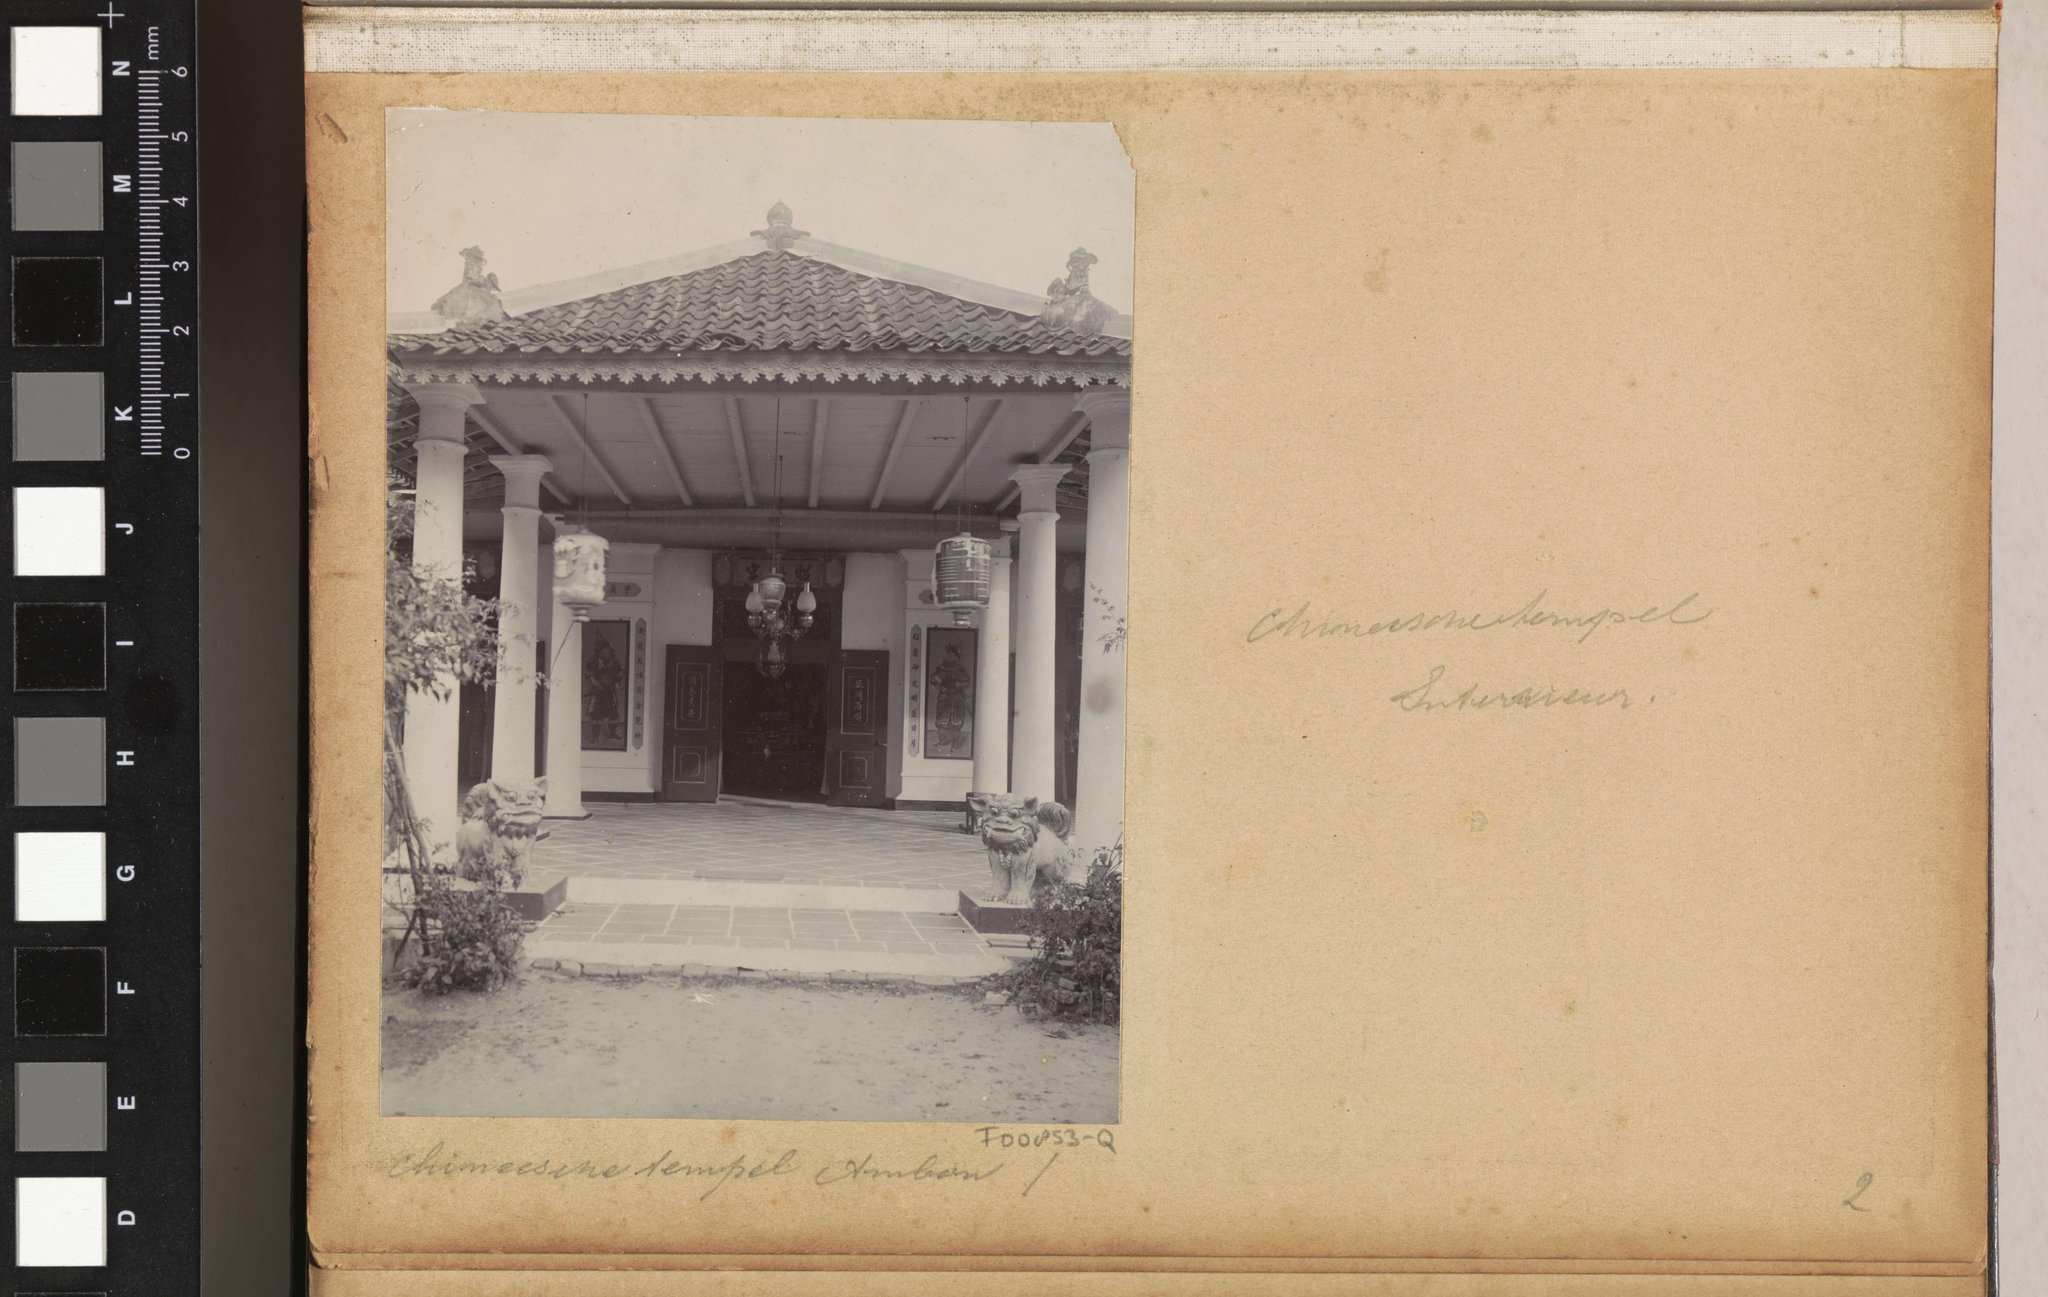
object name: photograph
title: Portaal van een Chinese tempel op Ambon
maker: Anonymous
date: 1900-1920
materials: cardboard, paper, photographic support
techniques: gelatin silver print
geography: ambon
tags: temple, shrine ~ hinduism, buddhism, jainism, dutch east indies, the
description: Onderdeel van Reisalbum met foto's van Ambon.